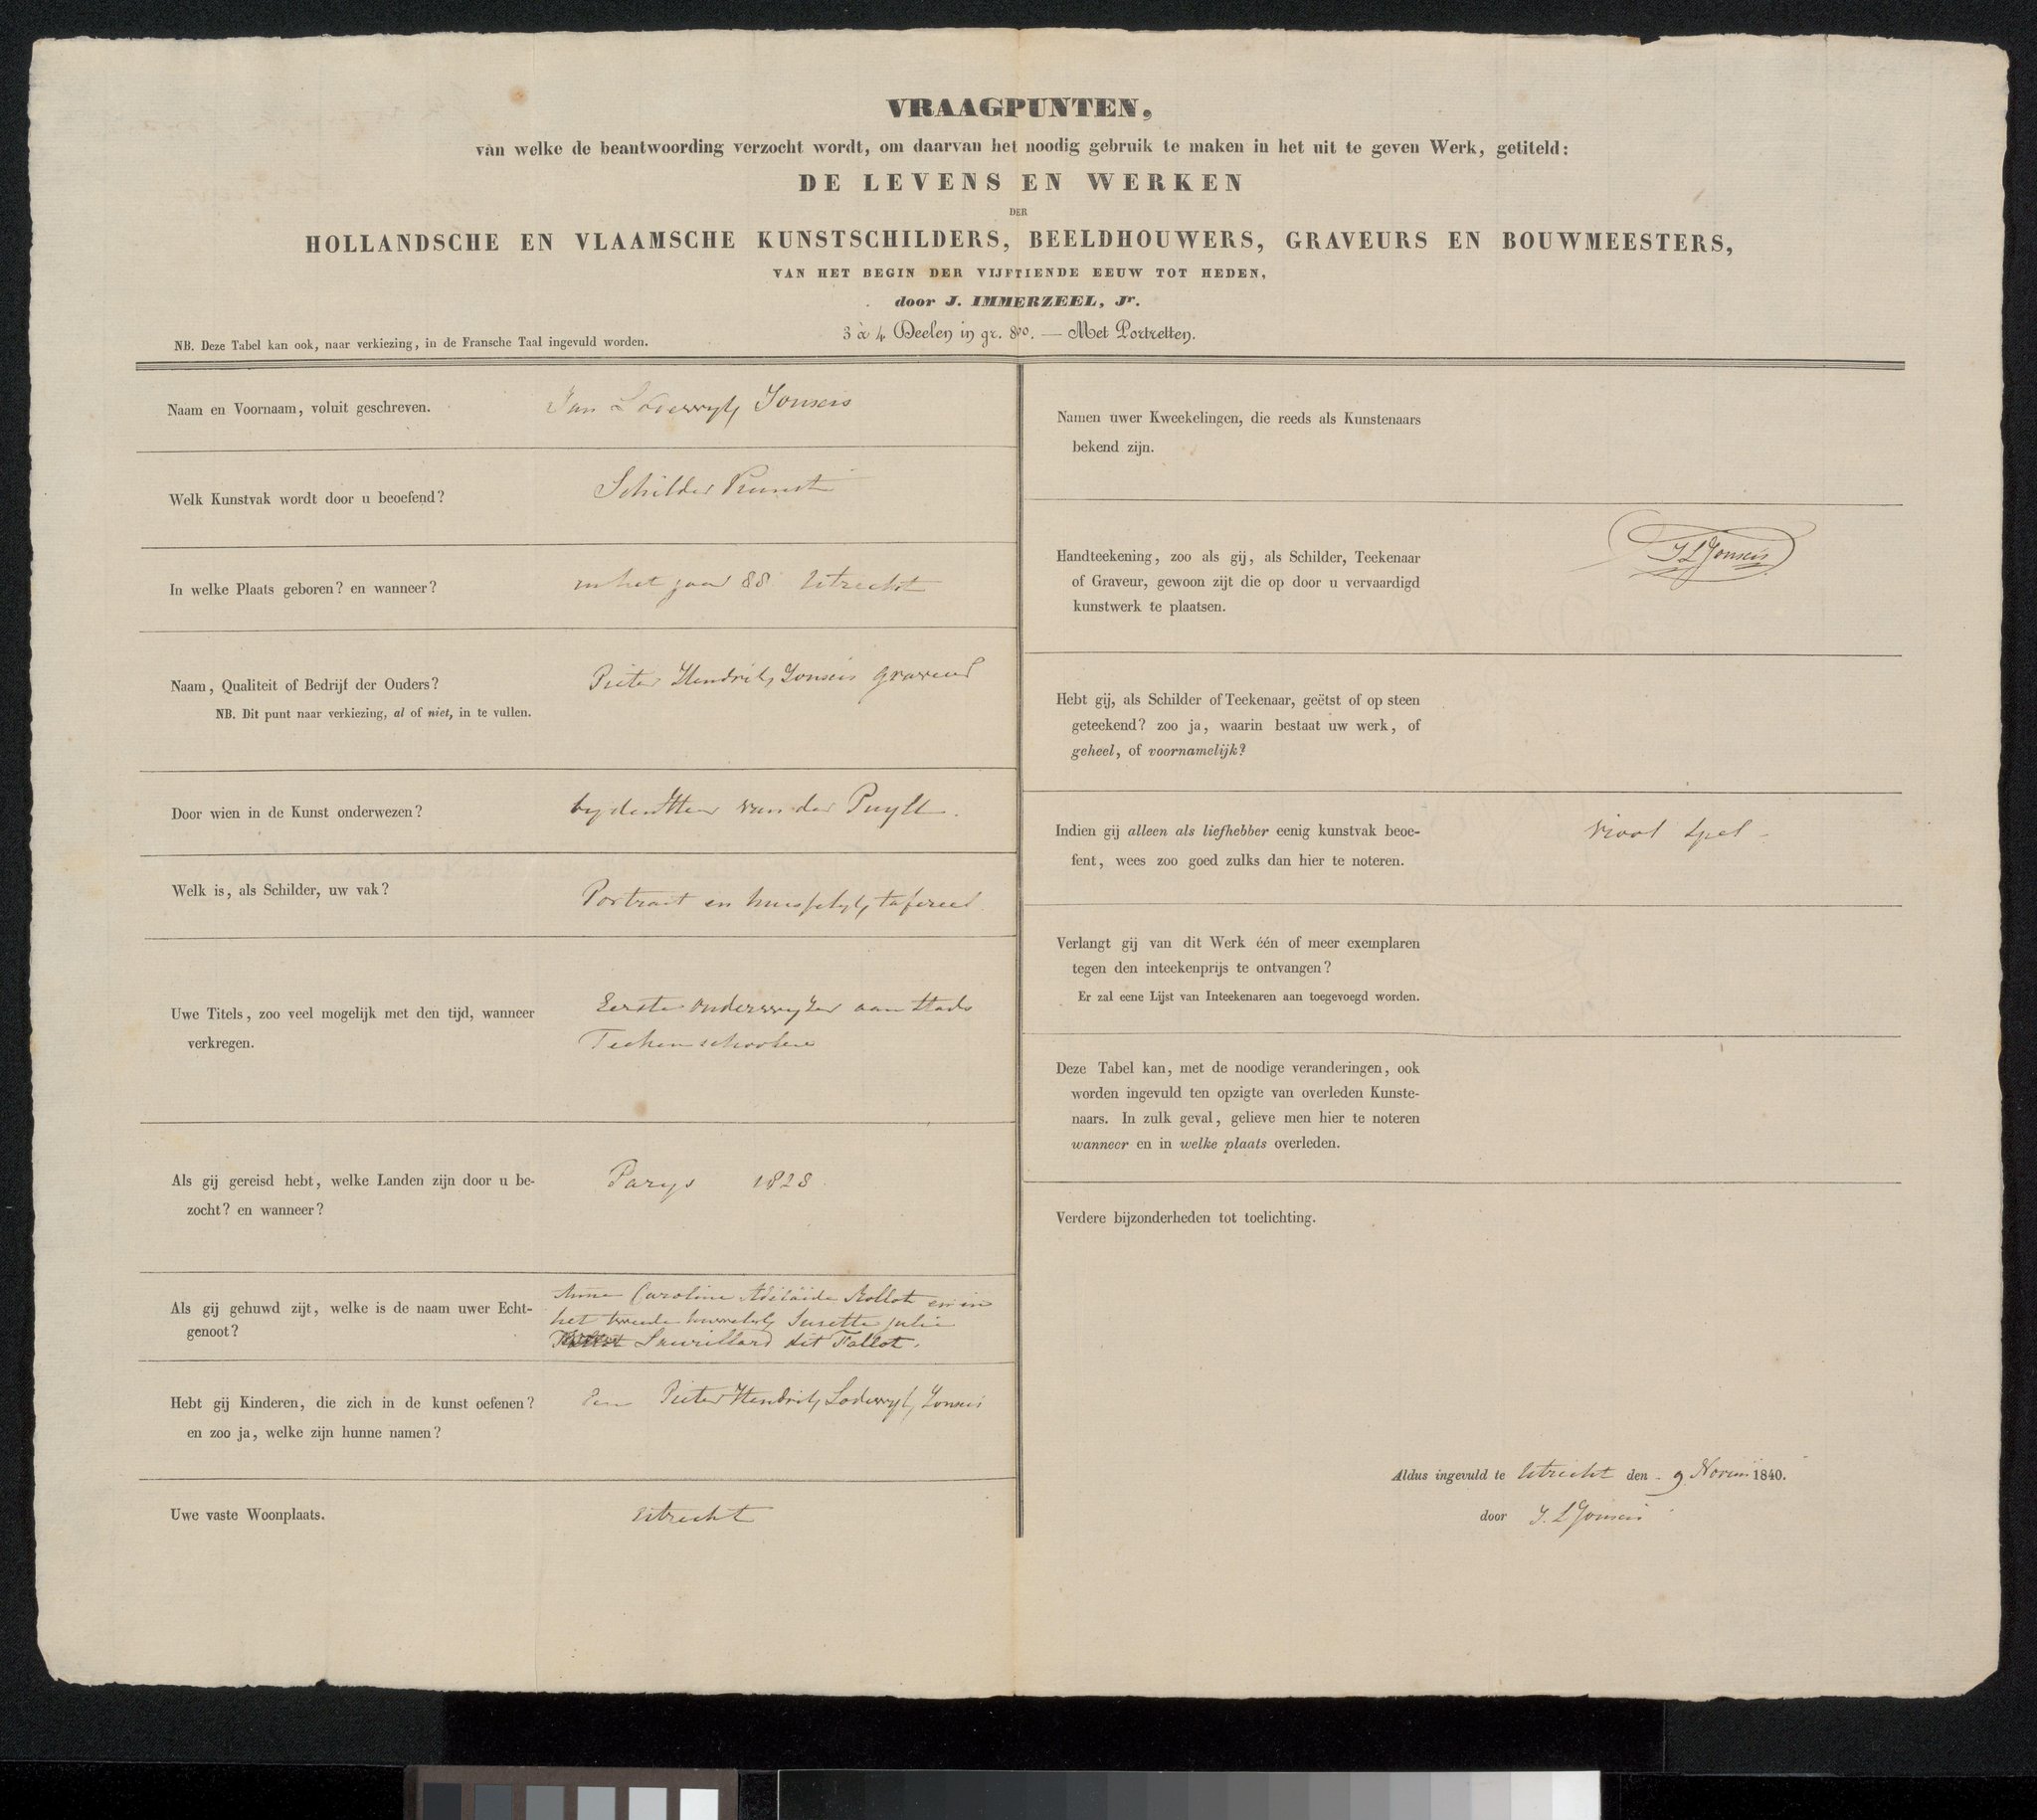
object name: manuscript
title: Enquêteformulier ingevuld door Jan Lodewijk Jonxis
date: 1840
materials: ink, paper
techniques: pen, printing, writing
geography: utrecht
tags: utrecht, painter, draughtsman, jan lodewijk jonxis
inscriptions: inscription: ‘Vraagpunten,/ van welke de beantwoording verzocht wordt, om daarvan het noodig gebruik te maken in het uit te geven Werk, getiteld: De levens en werken/ der Hollandsche en Vlaamsche kunstschilders, beeldhouwers,/ graveurs en bouwmeesters, van het begin der vijftiende eeuw tot heden/ door J. Immerzeel, Jr.’, watermark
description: Opgenomen in: Immerzeel, J. Jr., De levens en werken der Hollandsche en Vlaamsche kunstschilders, beeldhouwers, graveurs en bouwmeesters, van het begin der vijftiende eeuw tot heden, Amsterdam: J.C. van Kesteren, 1842-1843.